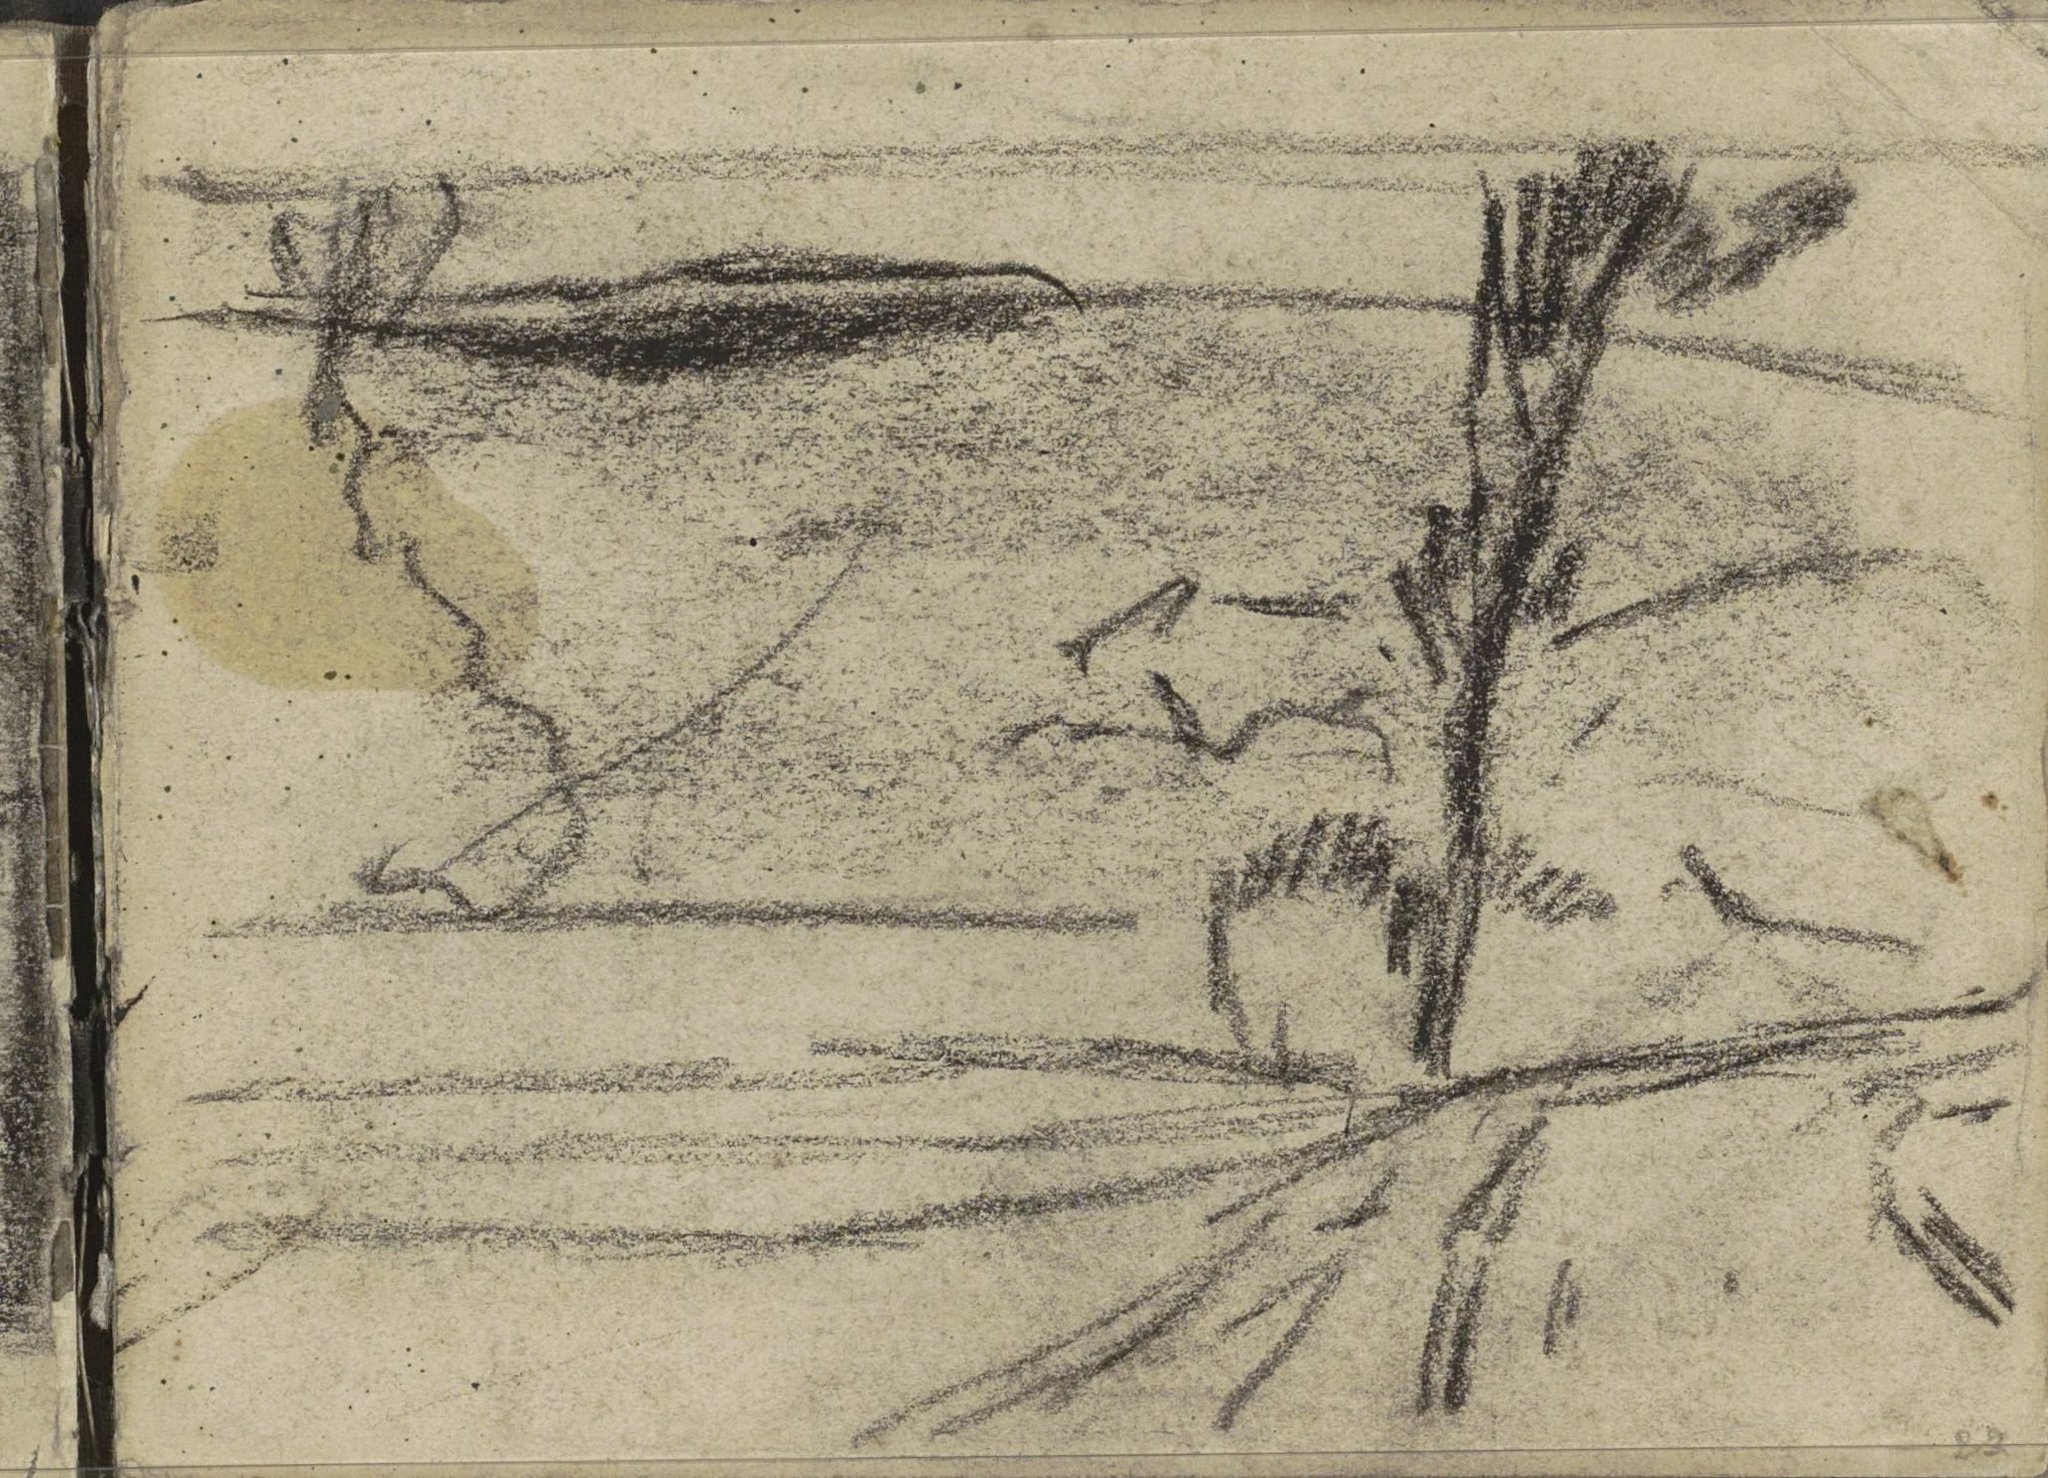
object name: sketchbook leaf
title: Pad in een landschap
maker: hermannus adrianus van oosterzee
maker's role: draughtsman, painter, print maker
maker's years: 1863-1933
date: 1893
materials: charcoal, paper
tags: landscapes, fence, wall, paling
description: Blad 22 recto uit een schetsboek met 23 bladen.